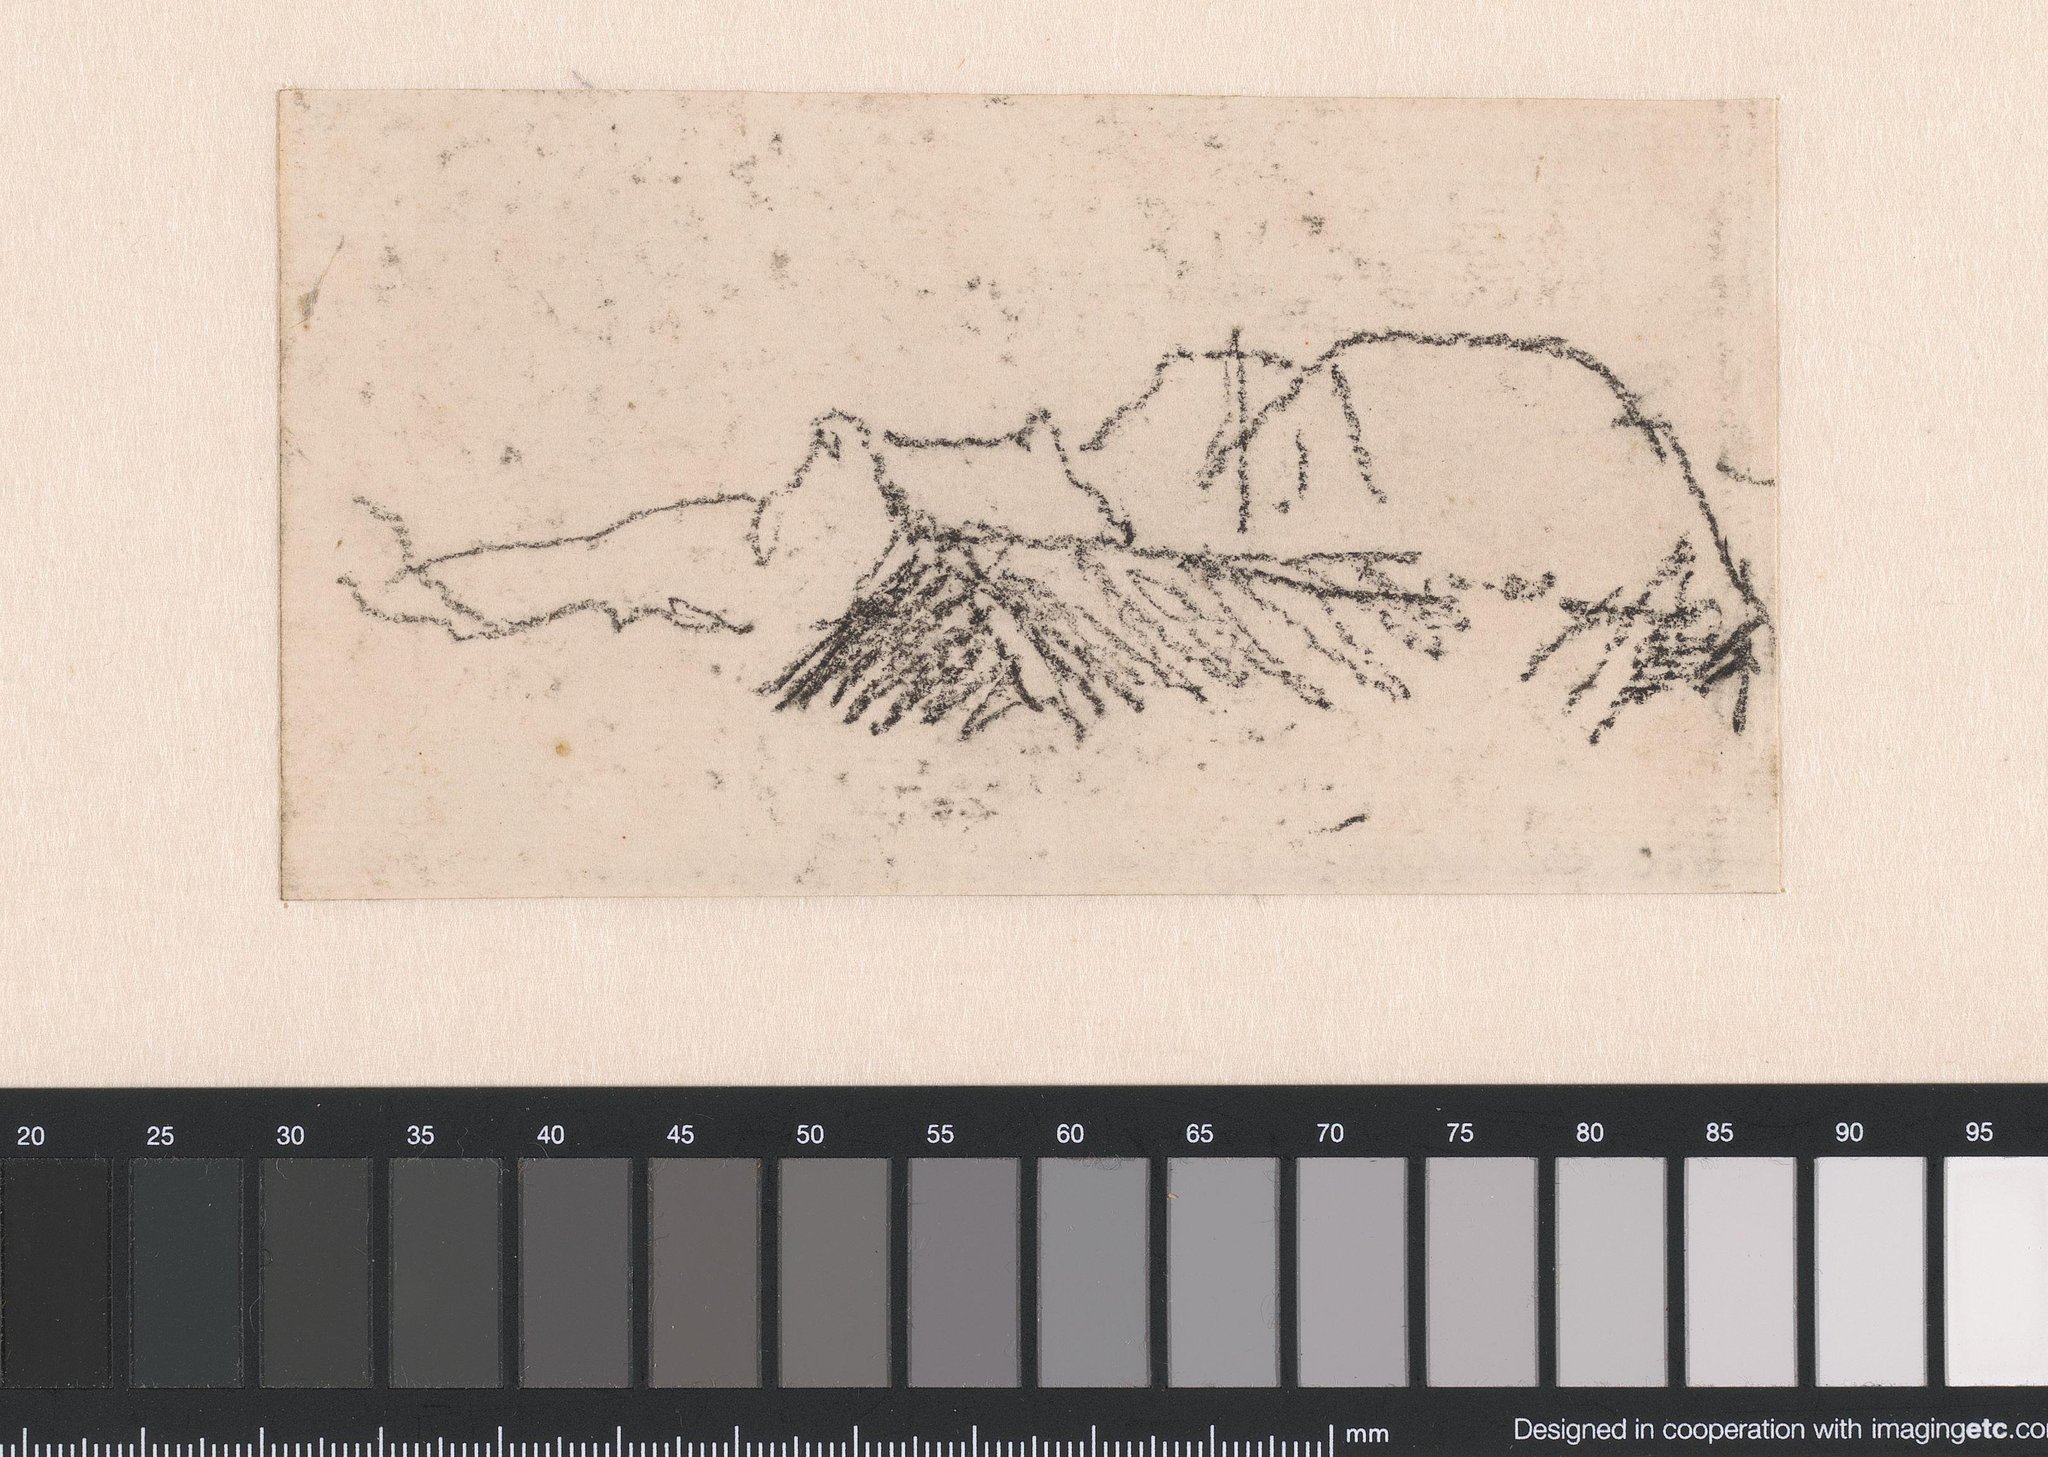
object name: drawing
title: Schetsblad met daken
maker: willem bastiaan tholen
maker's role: draughtsman, painter, print maker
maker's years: 1860-1931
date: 1870-1931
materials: chalk, paper